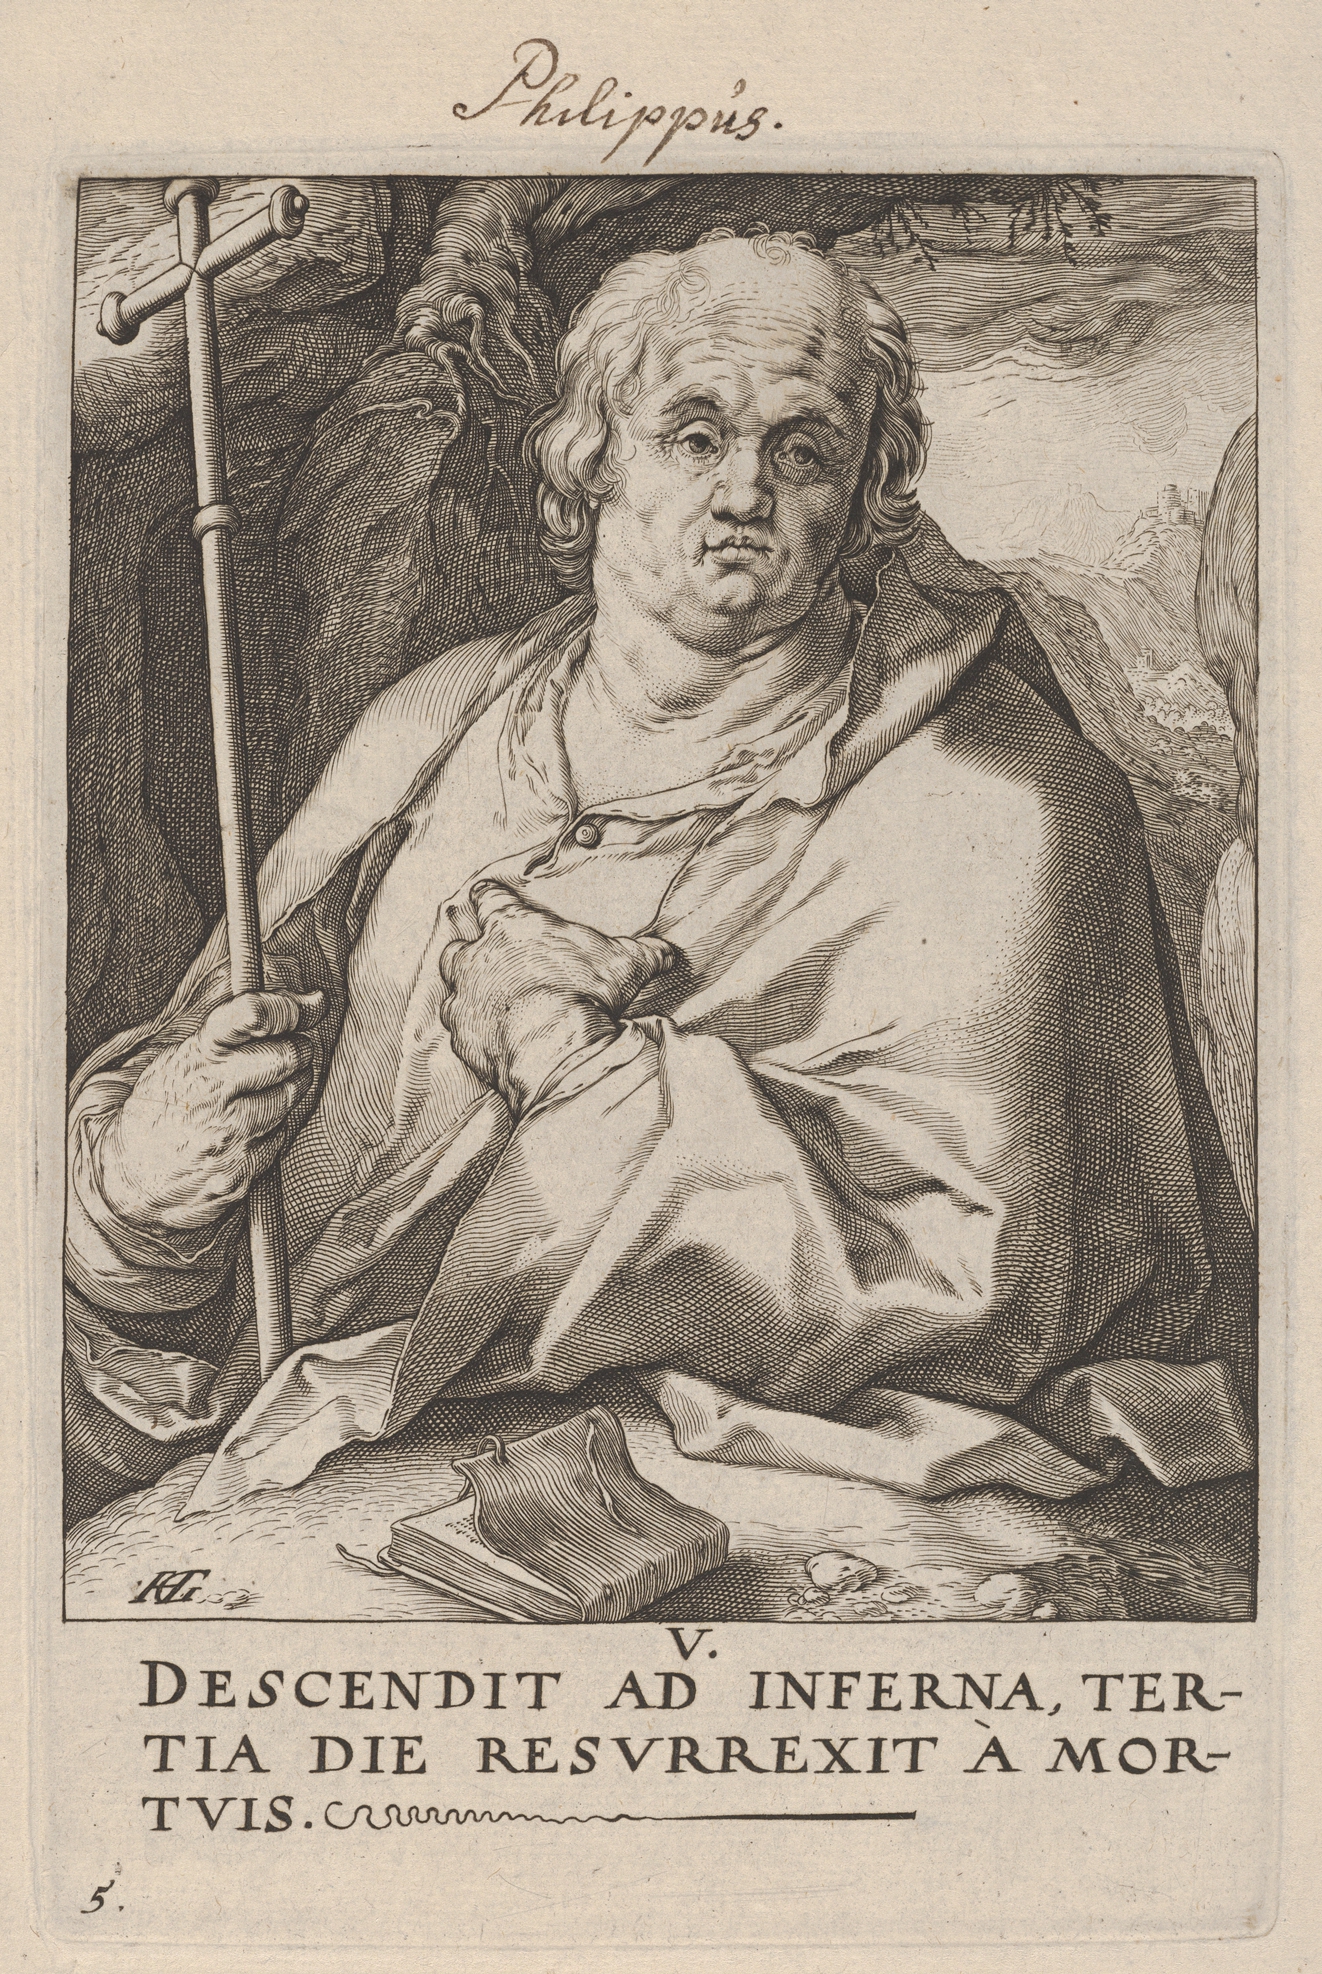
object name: print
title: St. Philip, from "Christ, the Apostles and St. Paul with the Creed"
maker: hendrick goltzius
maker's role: artist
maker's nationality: netherlandish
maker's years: 1558-1617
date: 1589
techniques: engraving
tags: men,saints